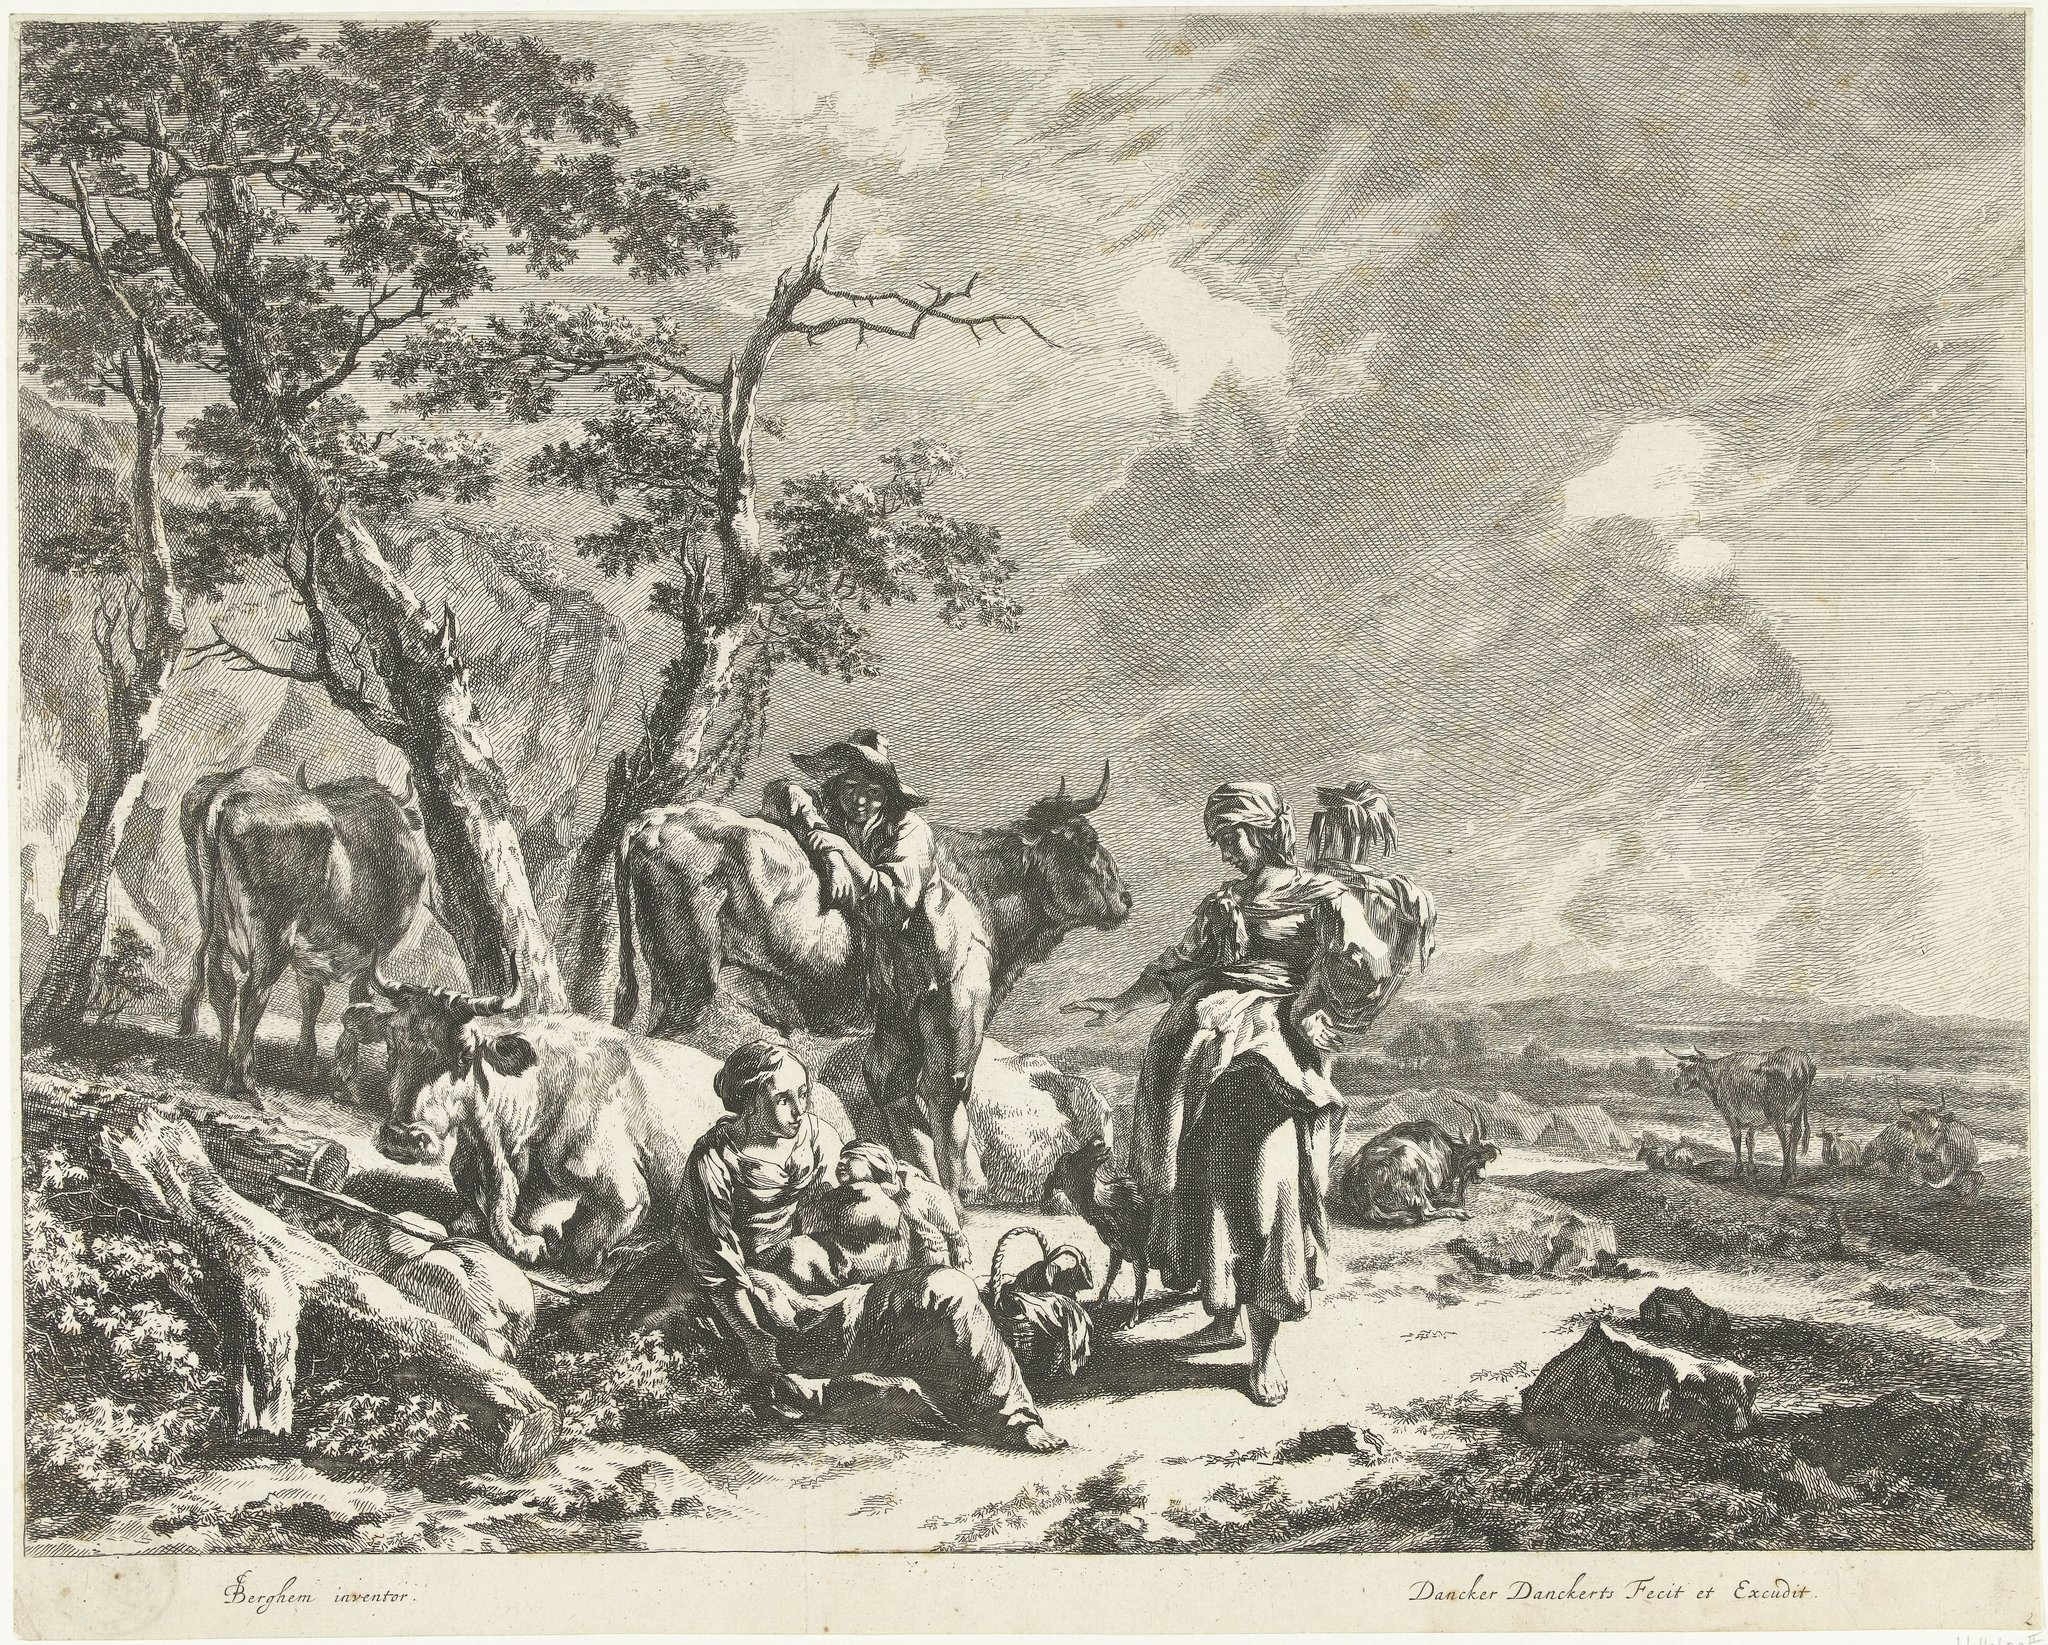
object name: print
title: Middag: herdersfamilie rust met kudde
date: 1660-1666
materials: paper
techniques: etching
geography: amsterdam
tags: herding, herdsman, herdswoman, shepherd, shepherdess, cowherd, etc., afternoon ~ other concepts, rocks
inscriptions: inscription: ‘Boek 41 N 1-3’, collector's mark: Lugt 11, collector's mark: Lugt 10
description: Herdersfamilie rust met kudde koeien bij bomen. Herderin zit met kind op schoot. Prent nummer 2 uit serie van vier prenten met tijden van de dag.